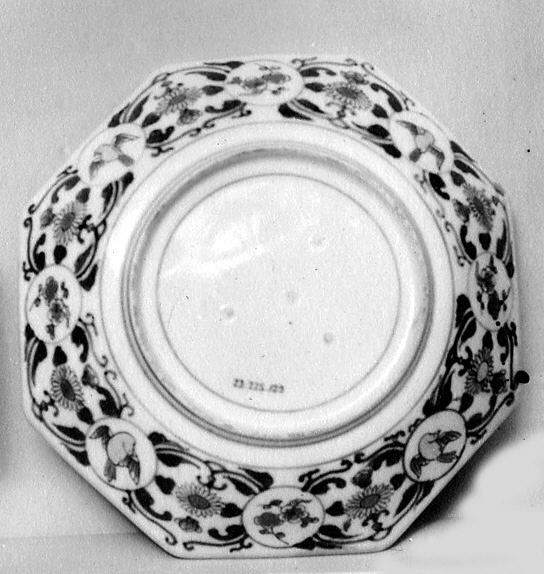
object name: plate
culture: japanese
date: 1750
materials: enamel, porcelain